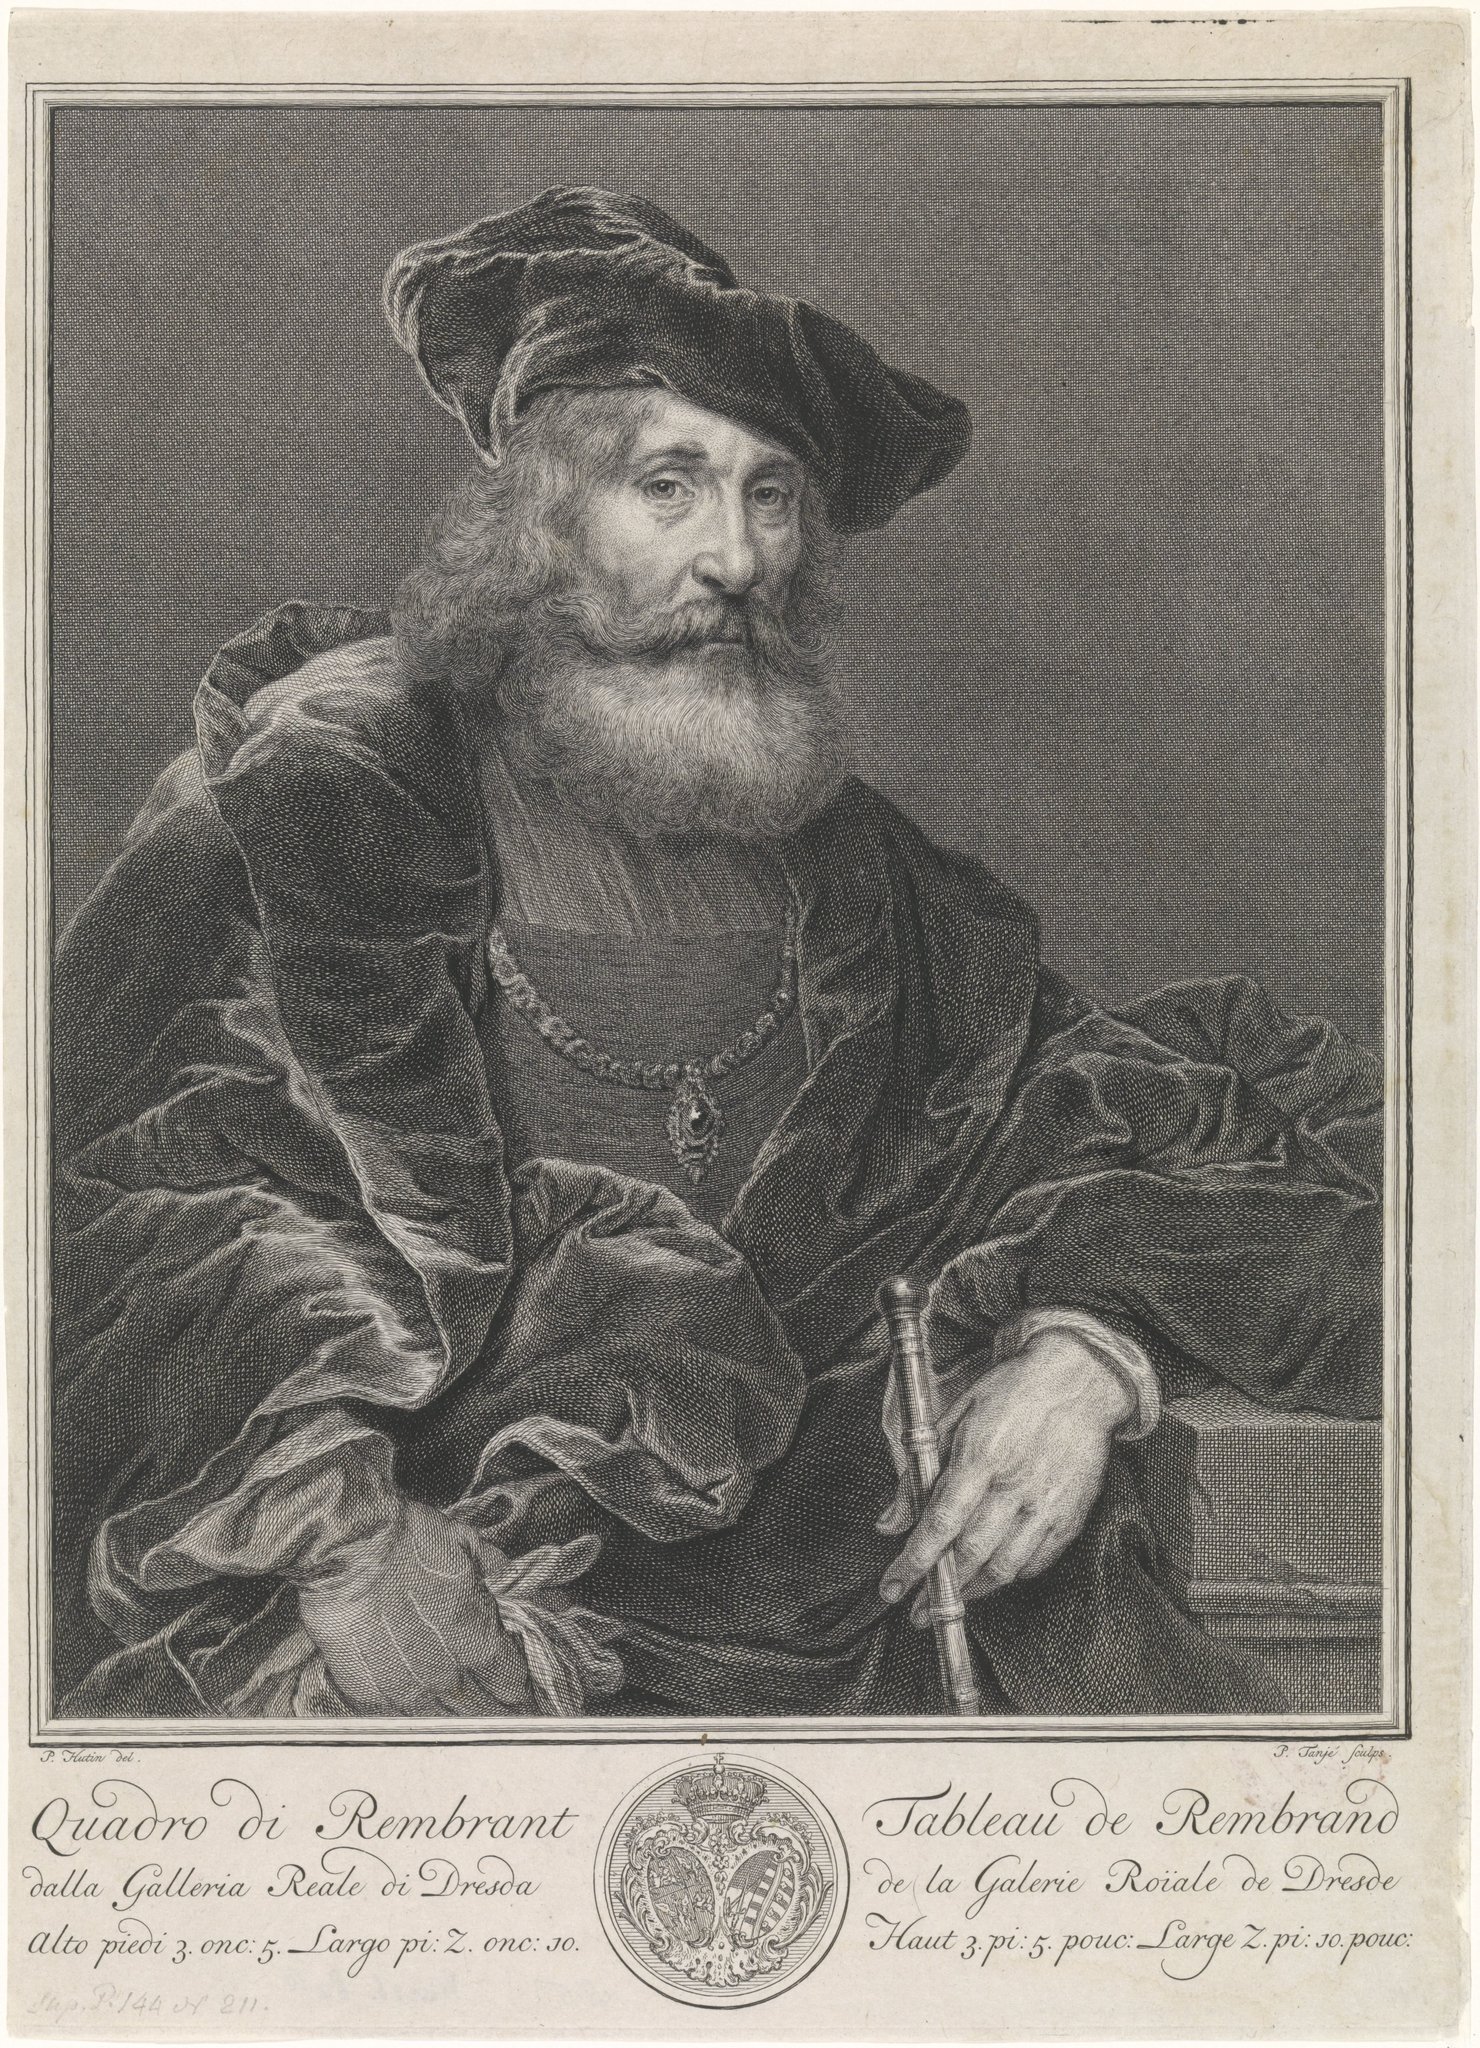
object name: print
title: Portret van een bebaarde man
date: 1716-1761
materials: paper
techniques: engraving, etching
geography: amsterdam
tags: head-gear: beret (+ men's clothes), beard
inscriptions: collector's mark: Lugt 240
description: Portret van een bebaarde man met een baret op het hoofd en een staf in de hand. Om zijn hals een ketting met een hanger. Onderaan in de marge de gekroonde wapenschilden van de keurvorsten van Saksen, de naam van de Koninklijke Verzameling in Dresden en de maten van het originele schilderij in het Italiaans en Frans.